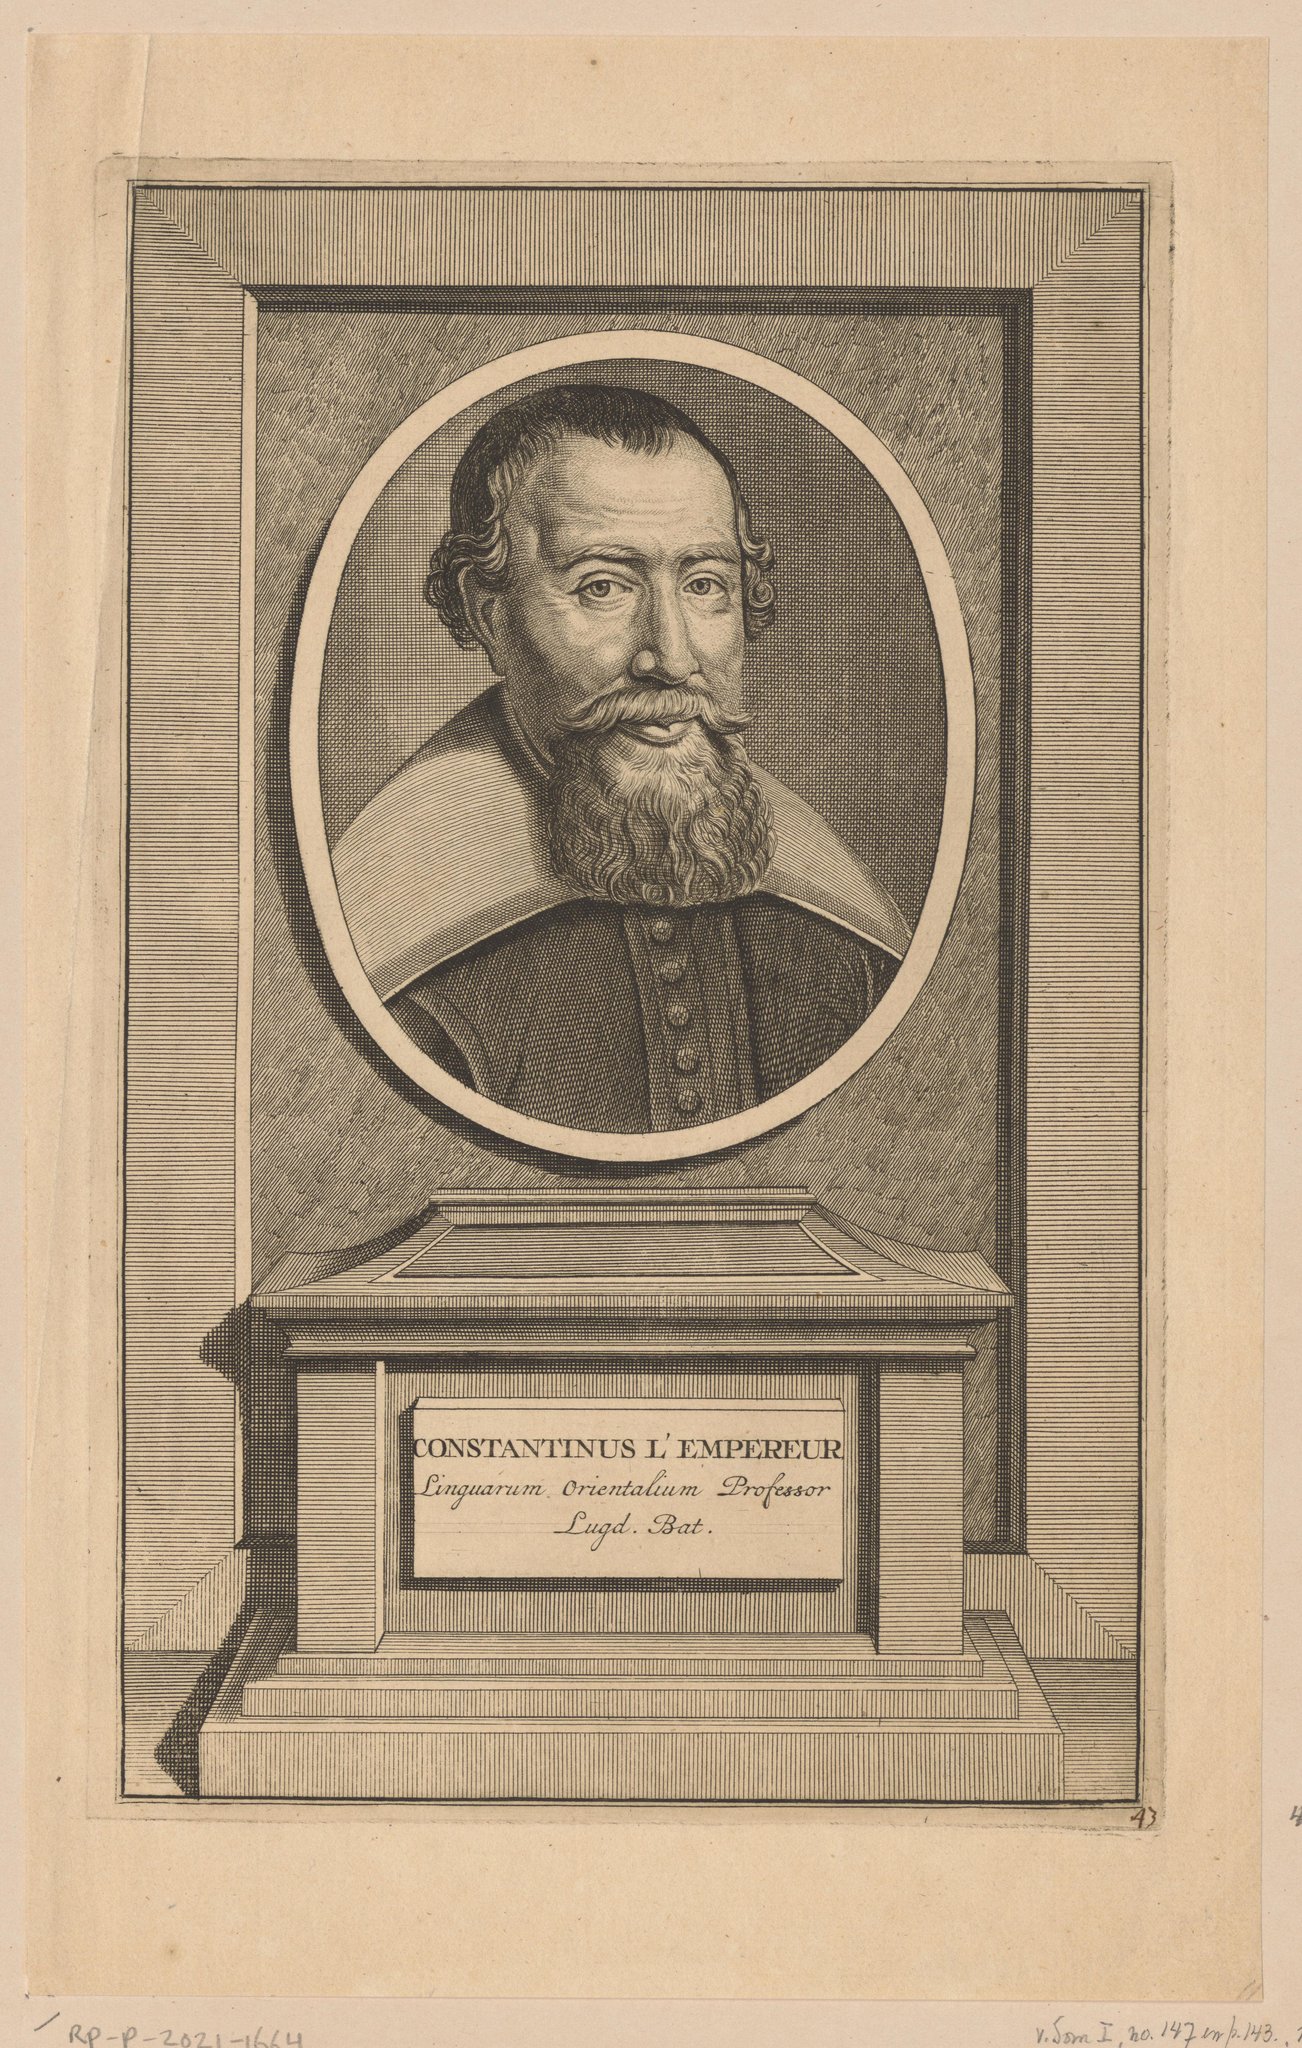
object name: print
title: Beroemde mannen aan de universiteit van Leiden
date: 1716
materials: paper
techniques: etching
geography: northern netherlands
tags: leiden, ornament ~ medallion, historical persons, professor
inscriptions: number: ‘43’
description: Deze prent is zonder omlijsting gedrukt, waarschijnlijk is in de serie een afdruk met omlijsting (gedrukt van een aparte plaat) gebruikt.